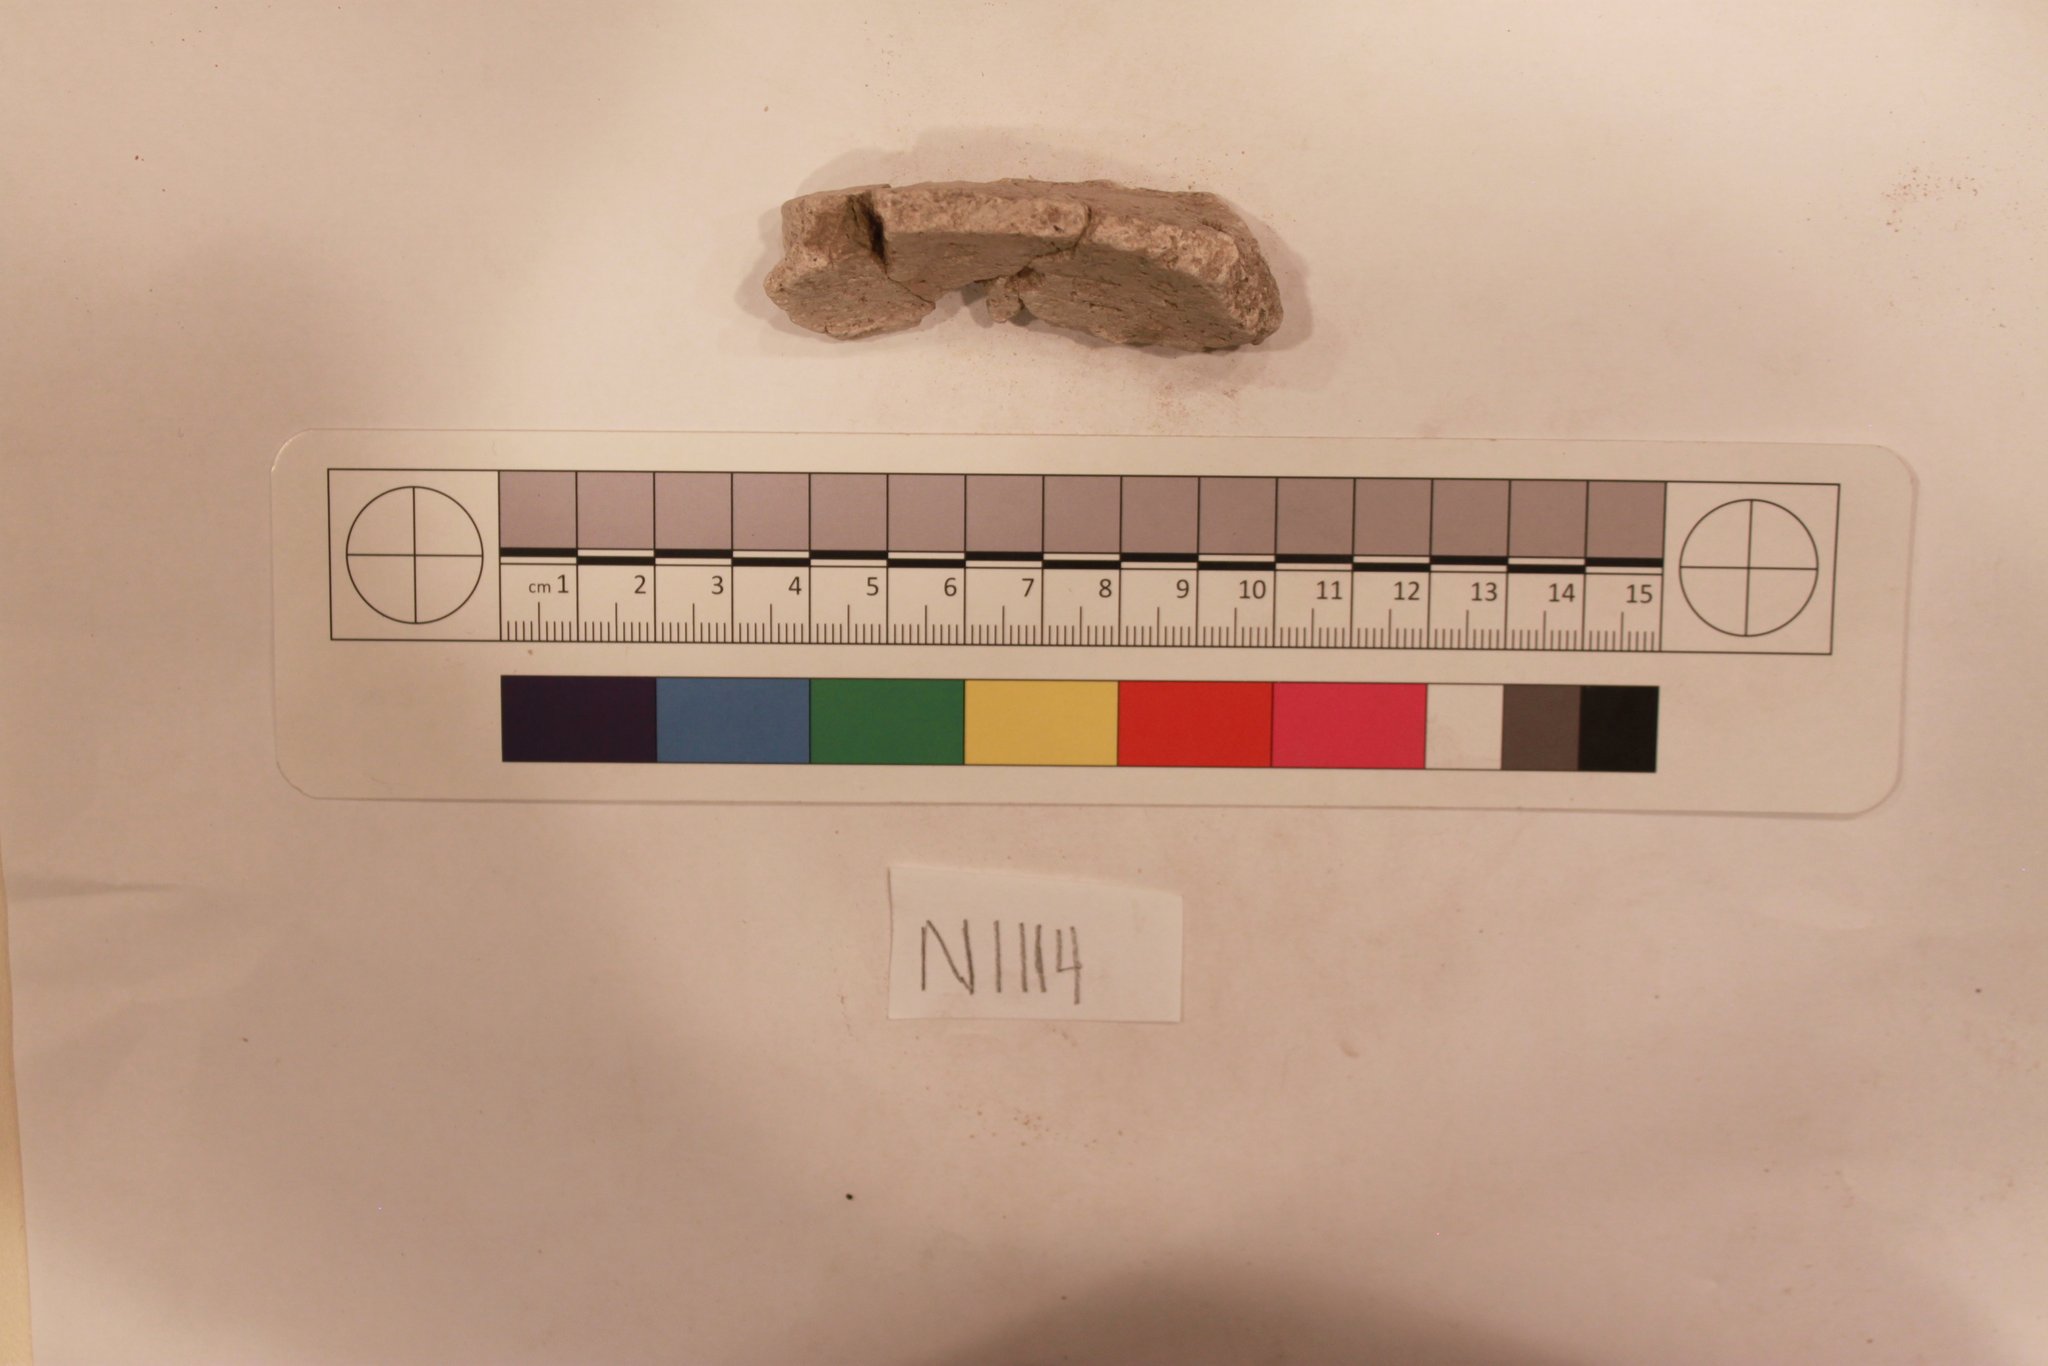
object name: fragment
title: Stucco Fragment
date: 701-1200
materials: plaster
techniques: carving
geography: iran